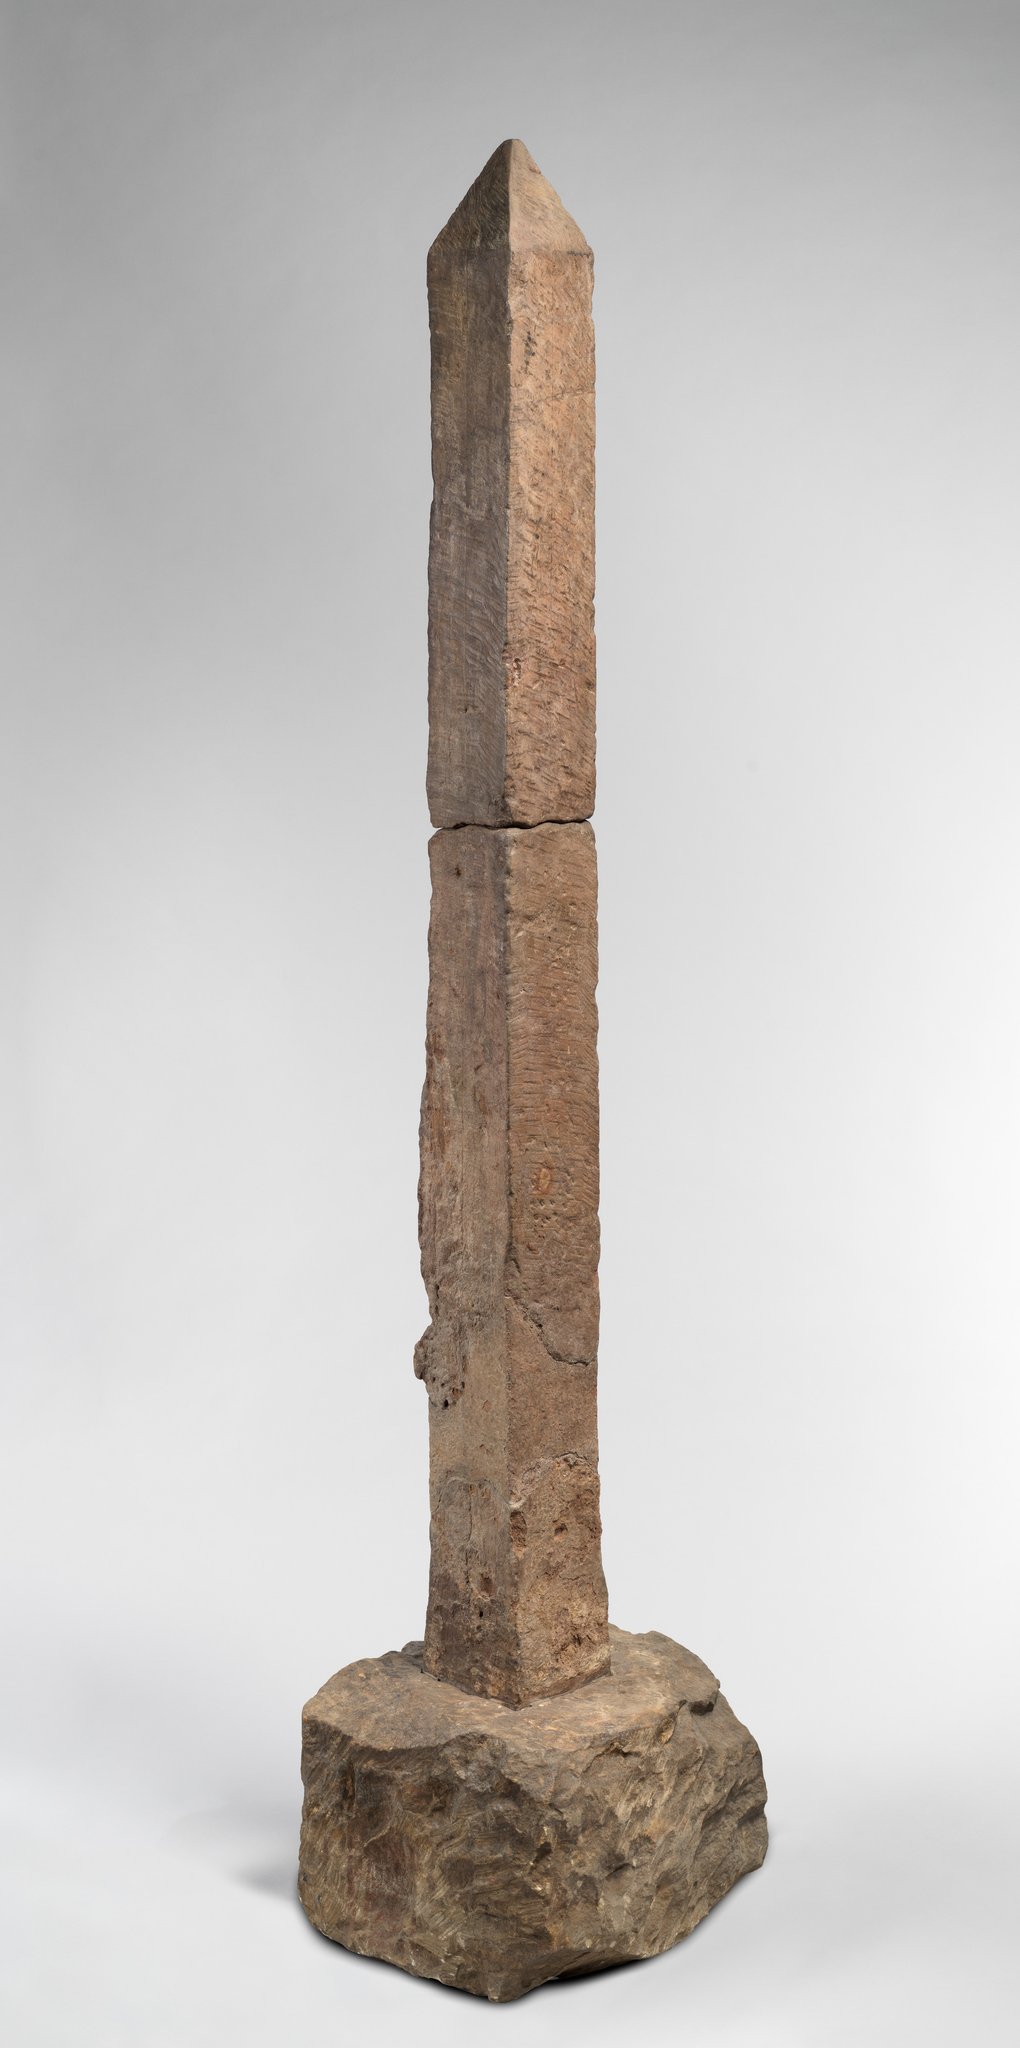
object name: obelisk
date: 332-330 BCE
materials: stone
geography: egypt